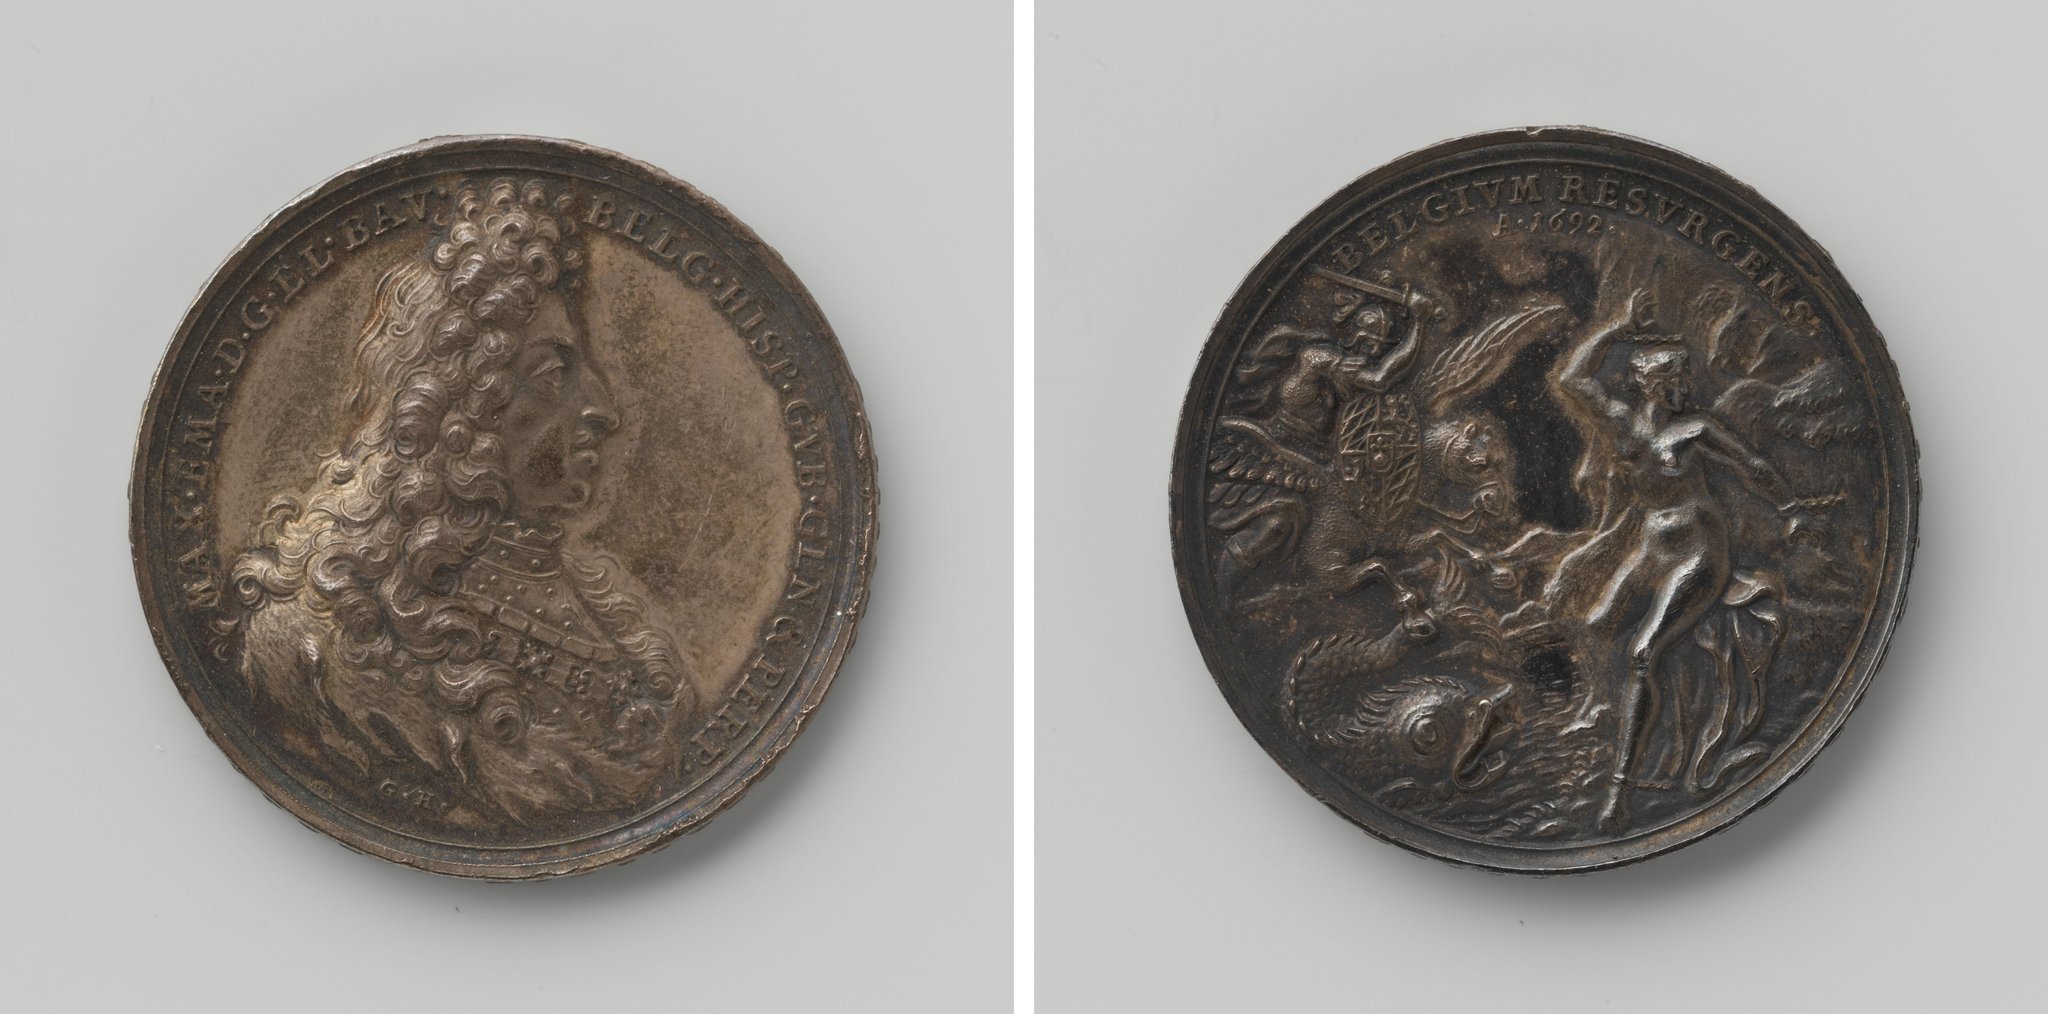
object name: history medal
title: Aankomst van Maximiliaan Emanuel, keurvorst van Beieren, landvoogd van de Spaanse Nederlanden te Brussel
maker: georg hautsch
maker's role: medailleur, muntmaker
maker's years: 1679-1745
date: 1692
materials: silver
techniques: striking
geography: nuremberg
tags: maximiliaan ii emanuel (keurvorst van beieren), southern netherlands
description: Zilveren penning. Voorzijde: borststuk man binnen omschrift. Keerzijde: Perseus komt Andromeda te hulp, die aan rots vastgeketend is binnen omschrift; randschrift